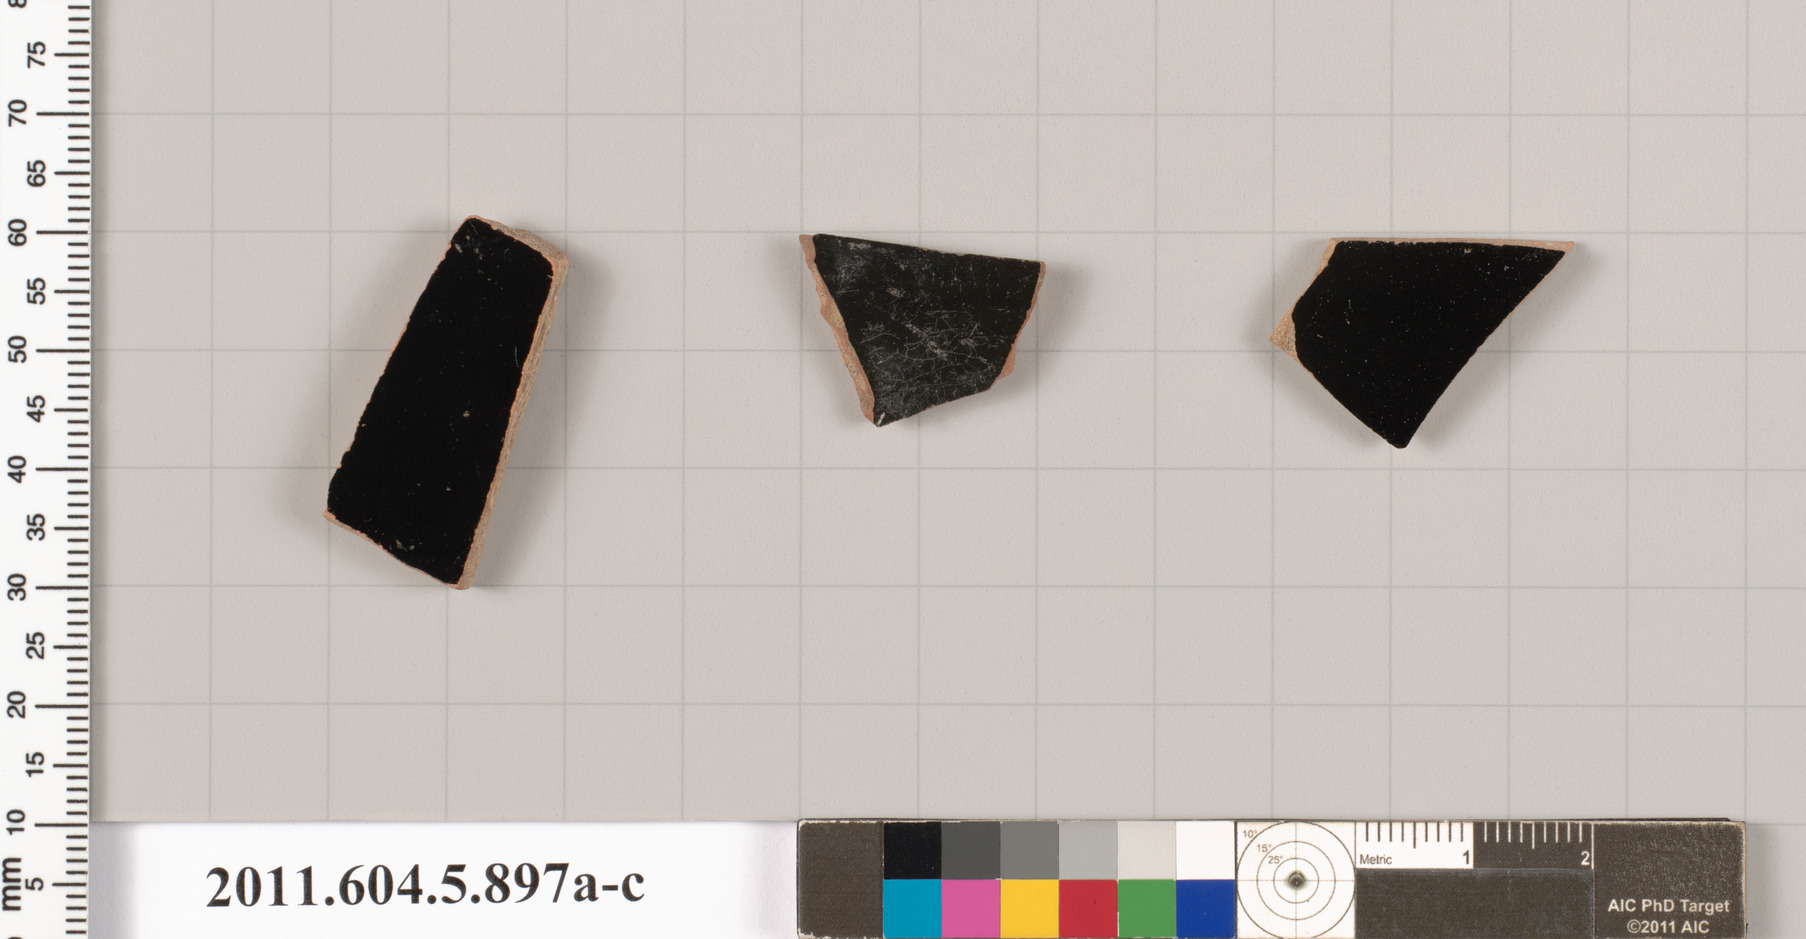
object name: kylix fragment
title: Terracotta fragments of kylikes (drinking cups)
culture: greek, attic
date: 600-401 BCE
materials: terracotta